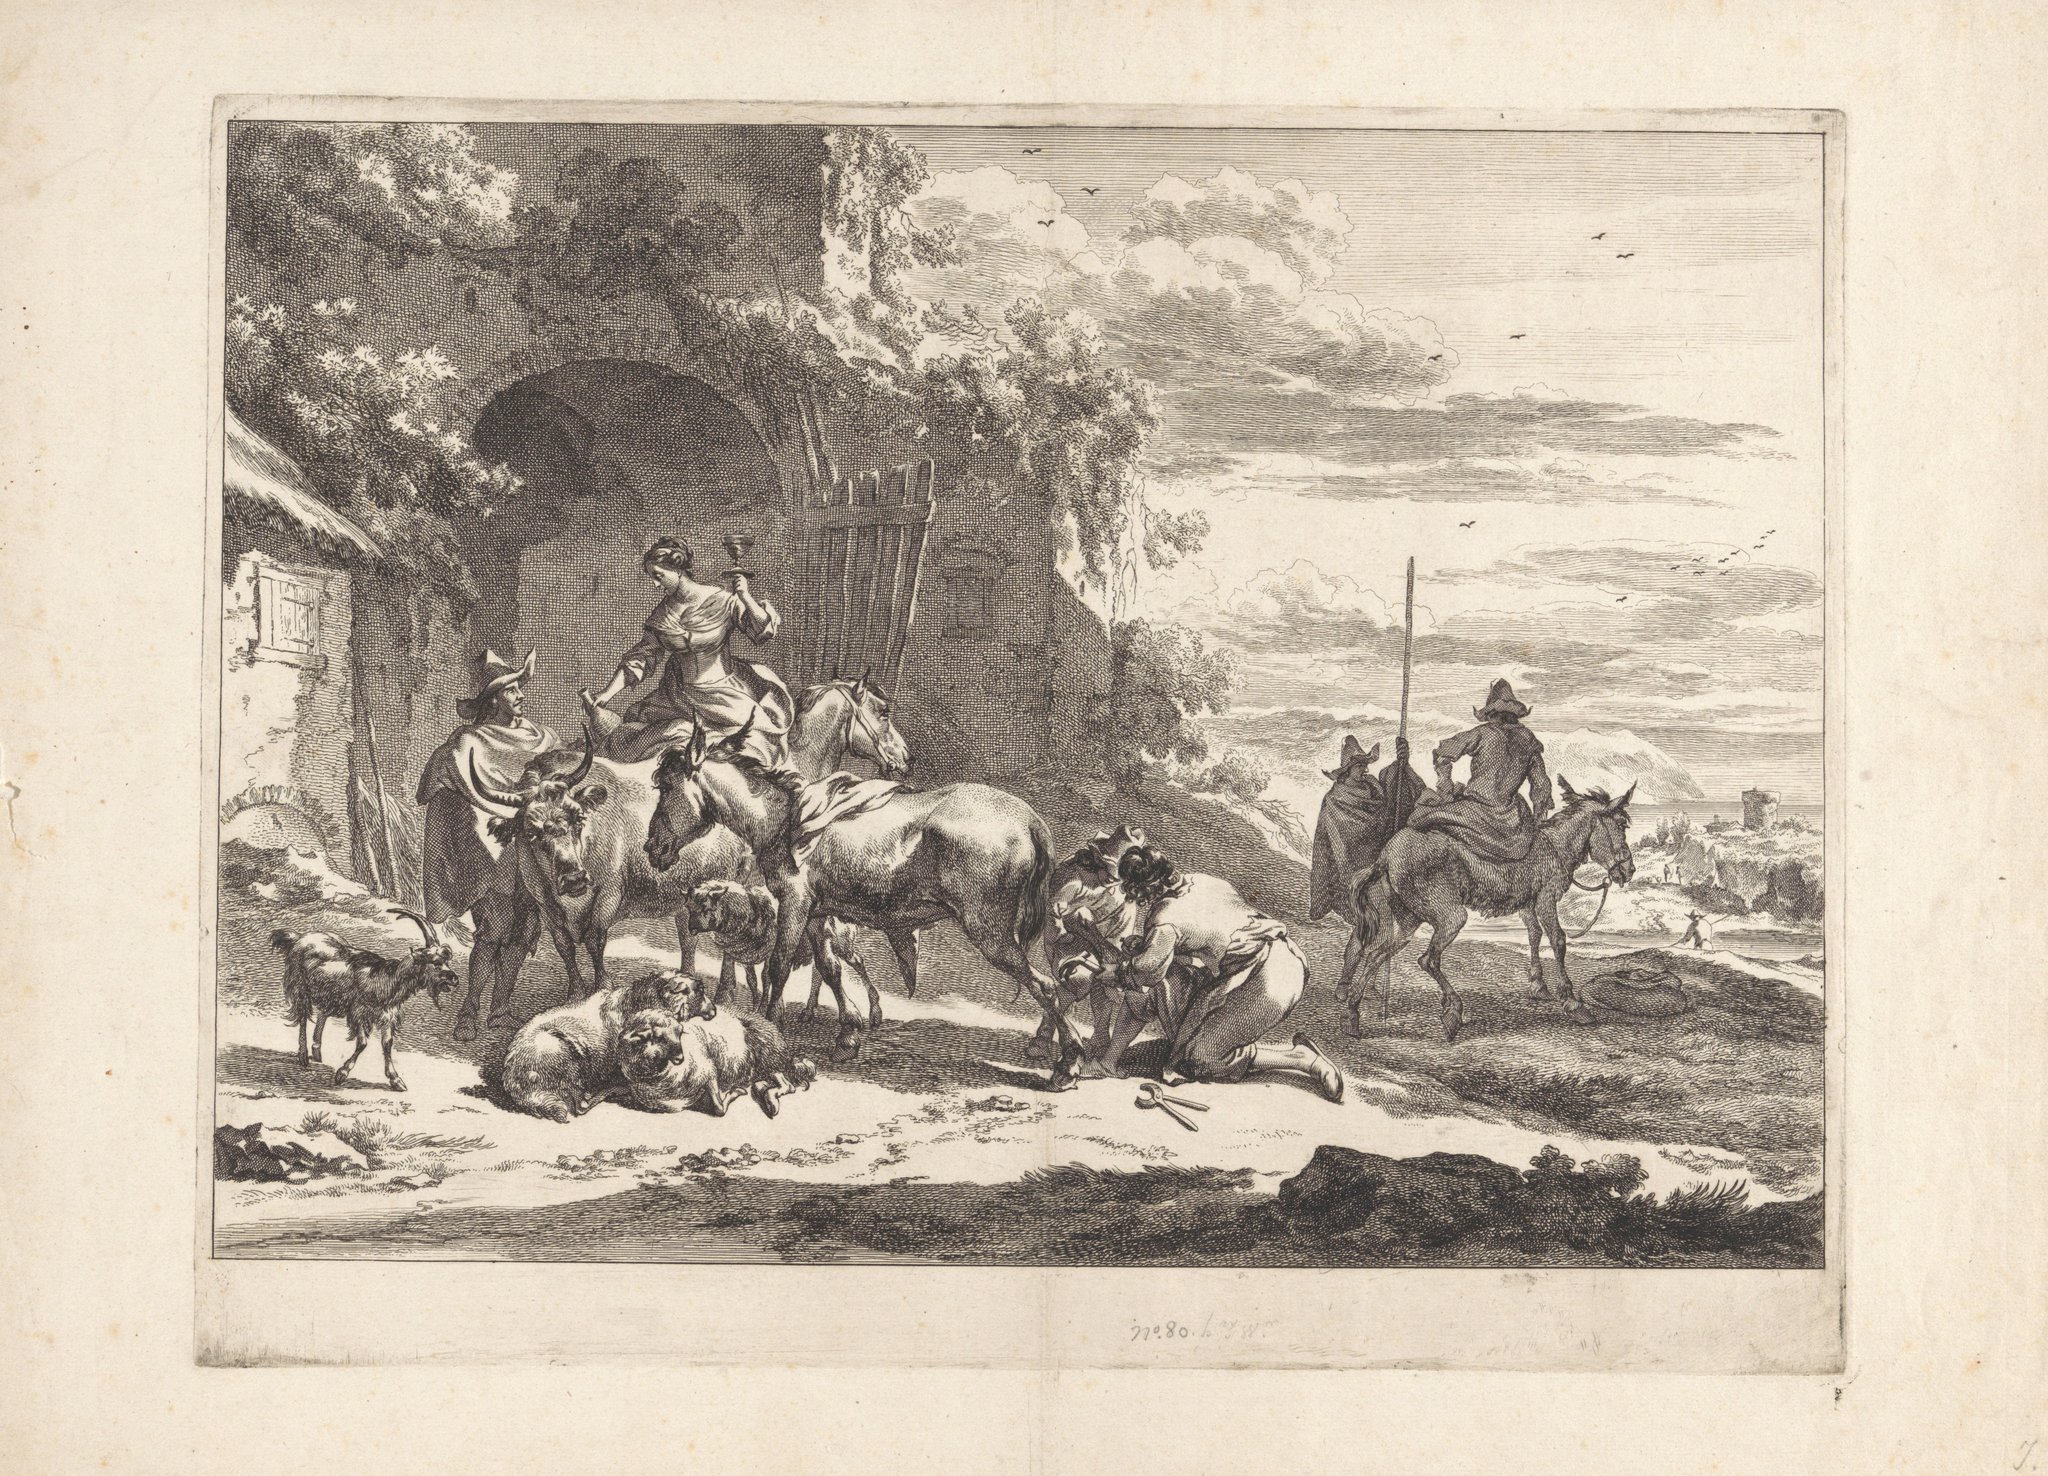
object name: print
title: Hoefsmid beslaat een ezel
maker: jan de visscher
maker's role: print maker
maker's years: 1633-1712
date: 1643-1692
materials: paper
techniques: engraving, etching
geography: northern netherlands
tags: cow, landscapes, farrier, shoeing-smith, ass, donkey, herding, herdsman, herdswoman, shepherd, shepherdess, cowherd, etc.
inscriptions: collector's mark: Lugt 2228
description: In een bergachtig landschap voor een met planten begroeid gebouw beslaat een hoefsmid een ezel. Voor de ezel staan een koe en een paard. Op het paard zit een dame met een glas wijn.